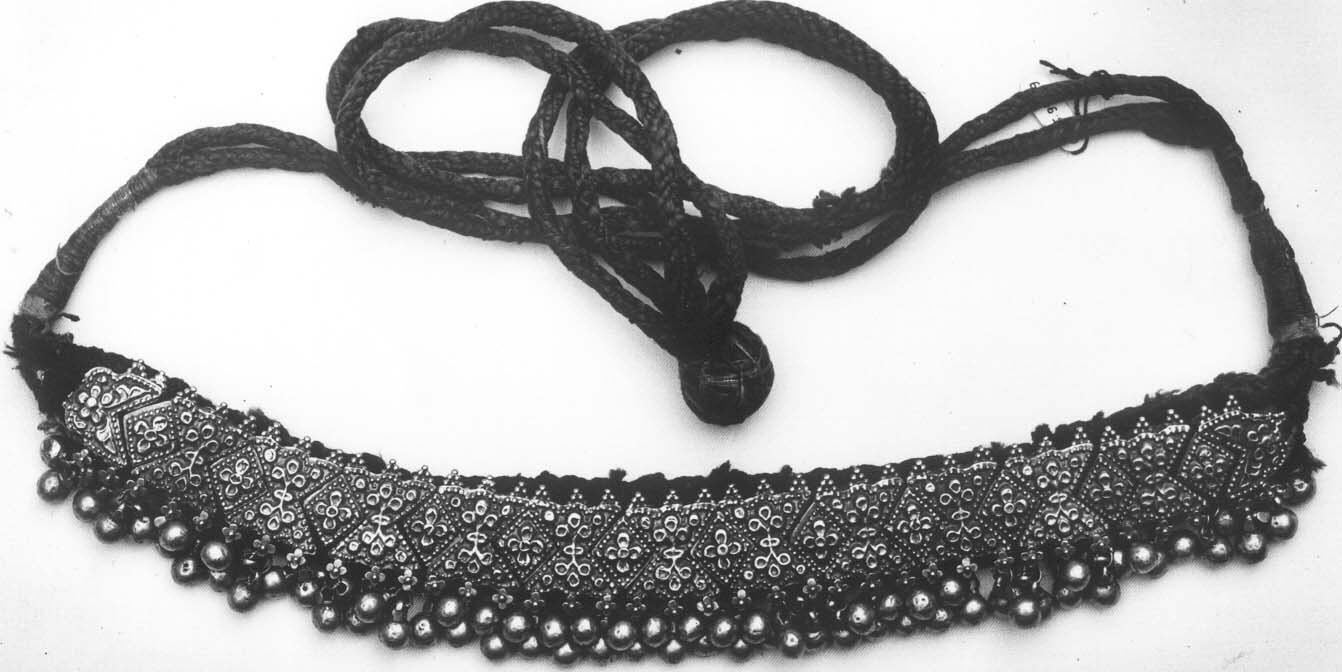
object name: necklace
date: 1701-1900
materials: gold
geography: india